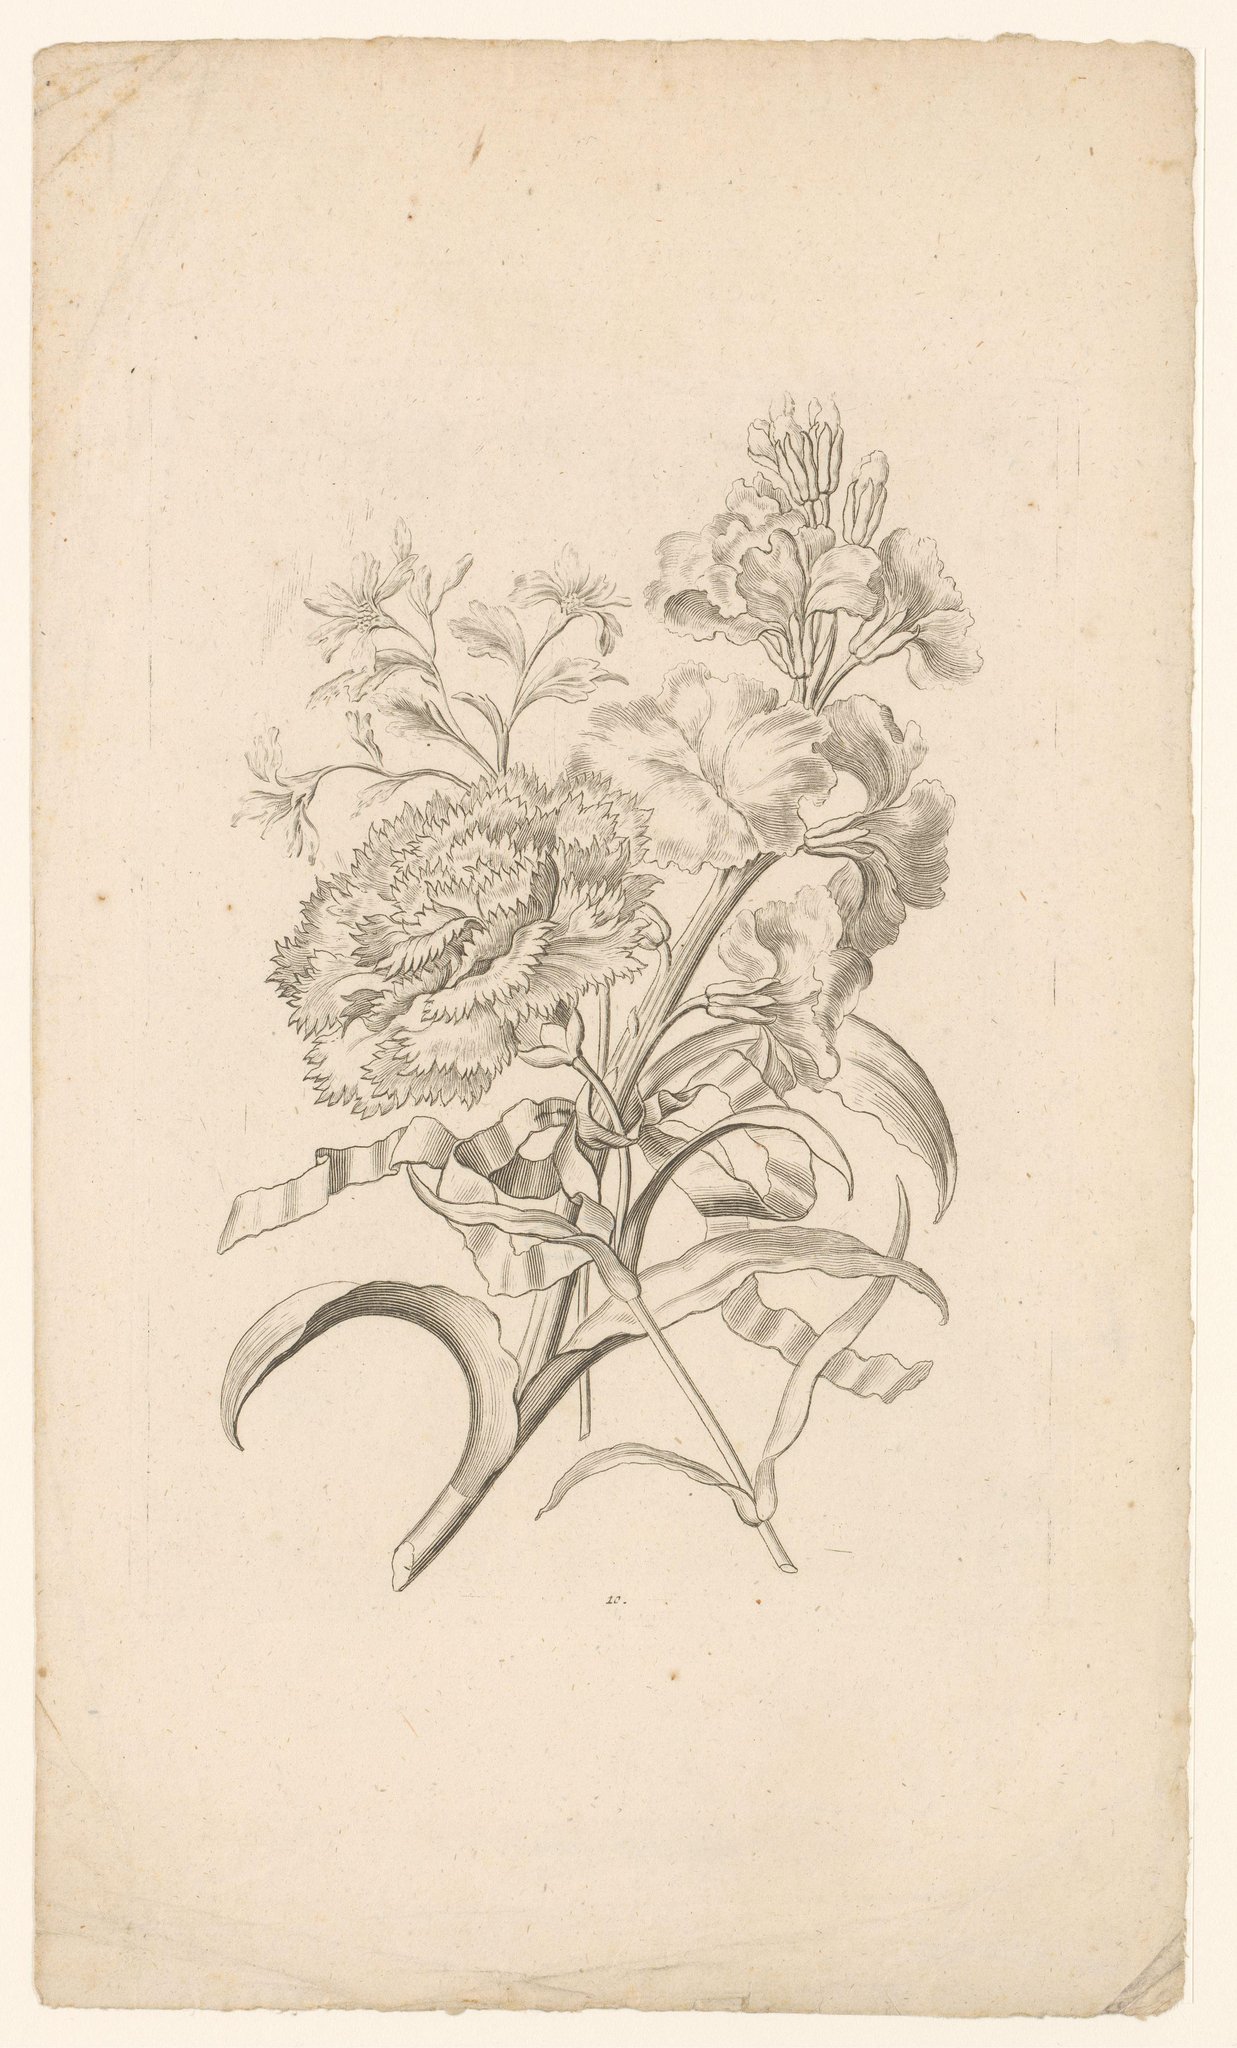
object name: print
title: Bos met lelies, roos en andere bloemen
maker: Anonymous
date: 1700-1800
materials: paper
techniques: engraving, etching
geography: netherlands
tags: cut flowers; nosegay, bunch of flowers, flowers: lily, flowers: rose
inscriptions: collector's mark: Lugt 2228